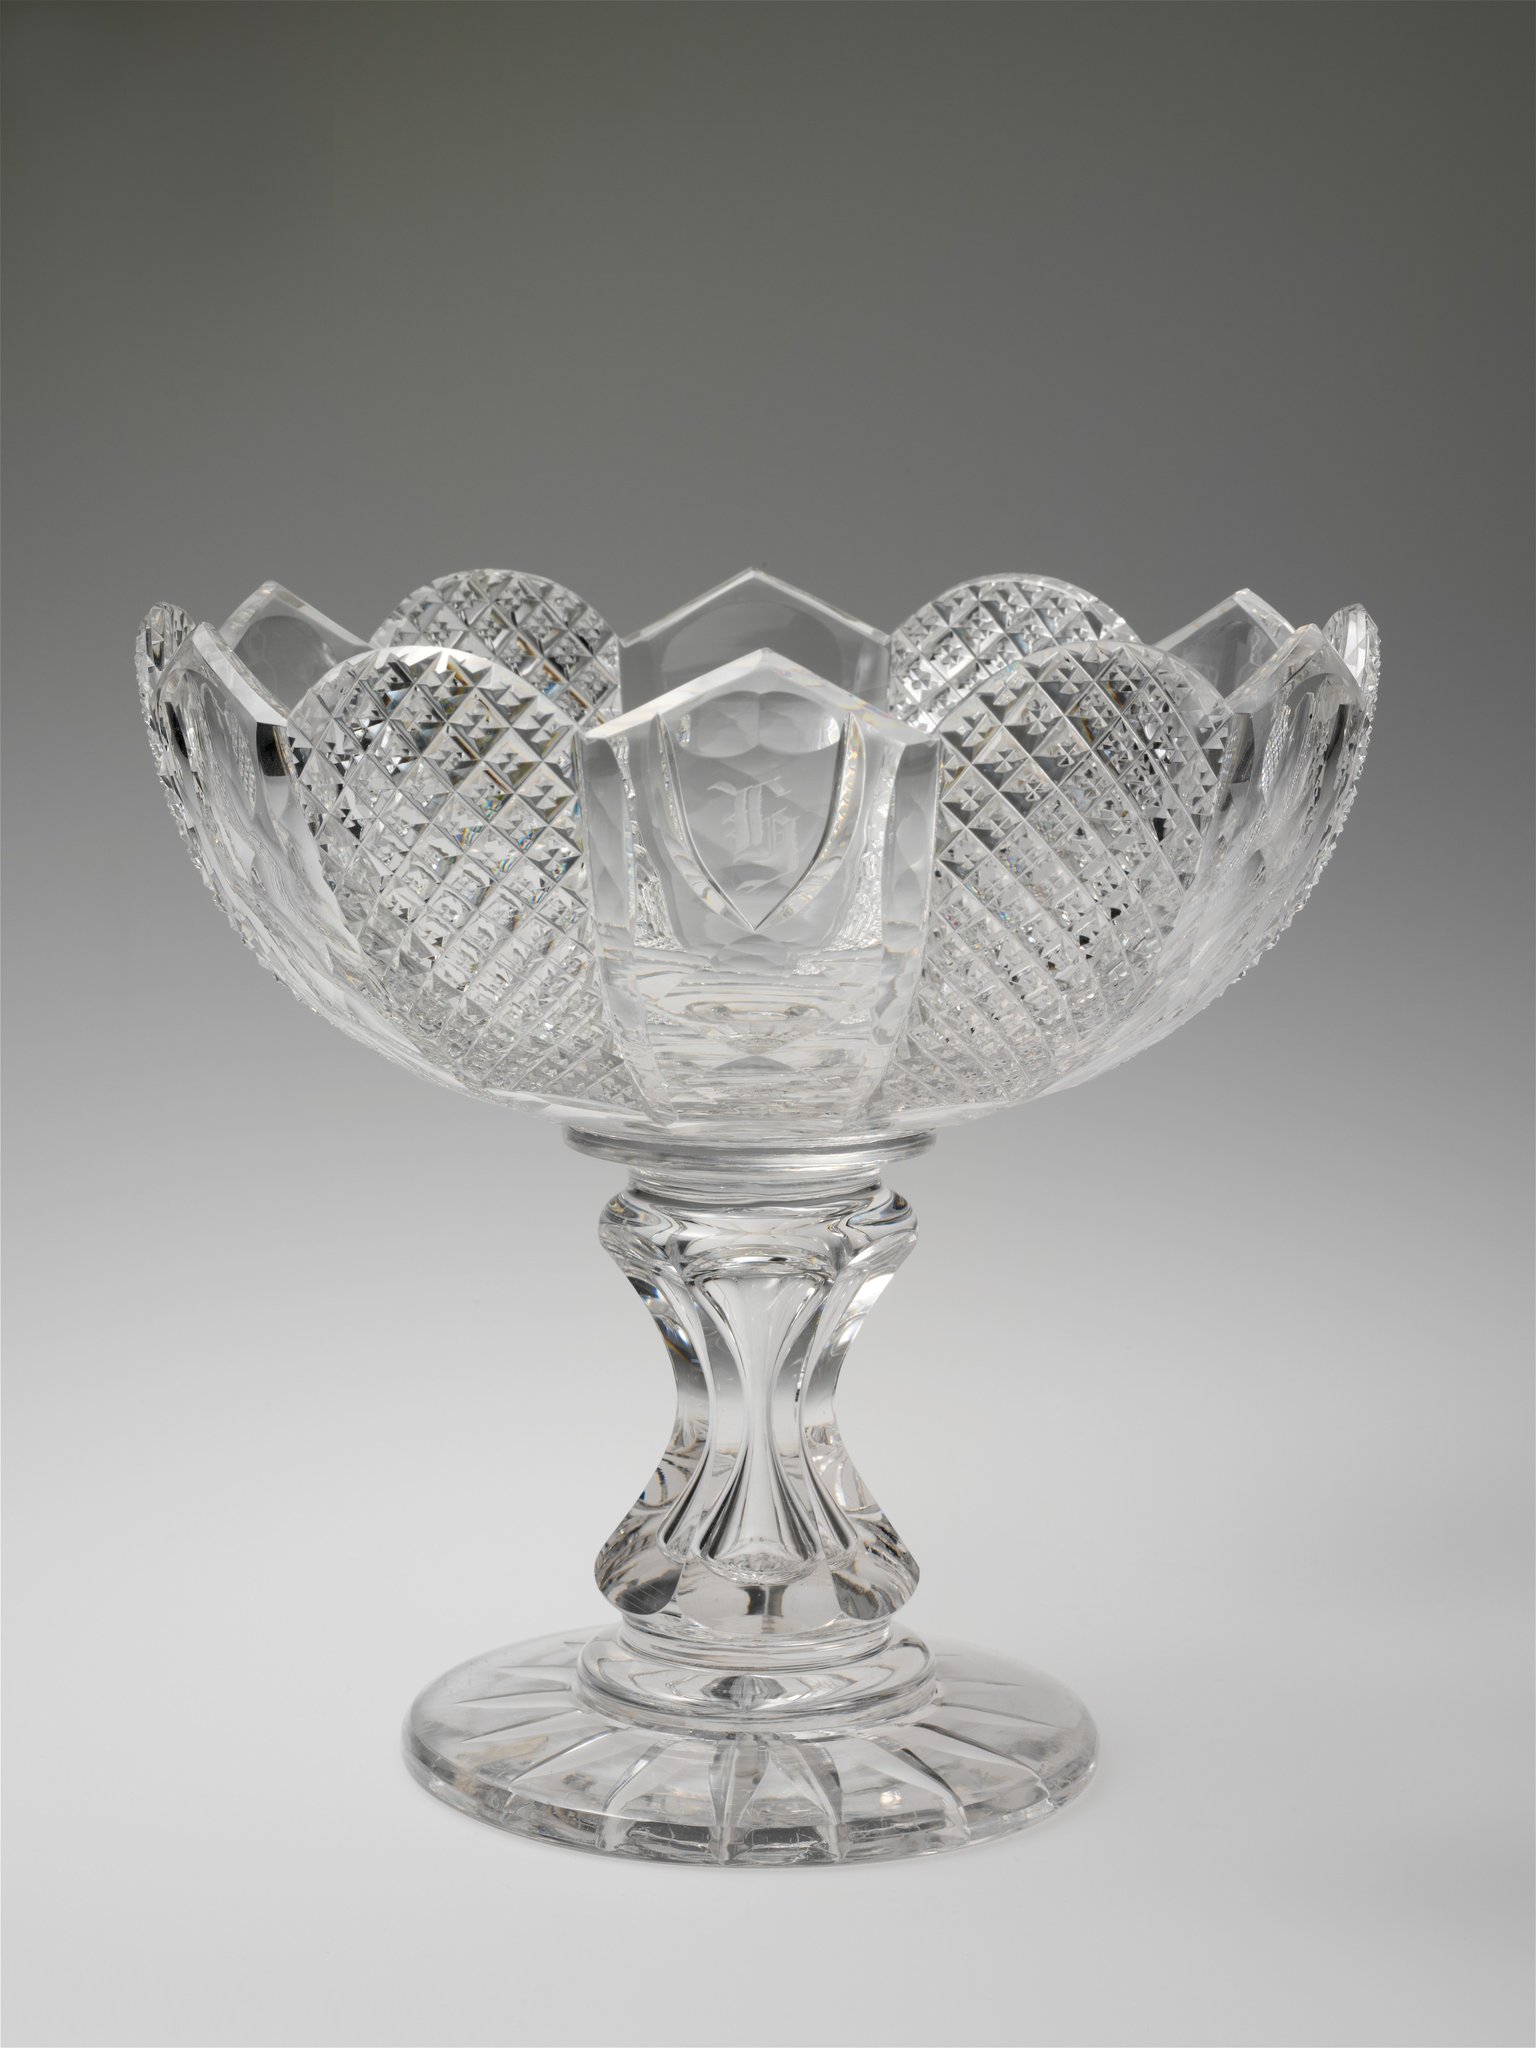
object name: compote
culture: american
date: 1855-1860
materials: glass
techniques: cutting, engraving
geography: united states